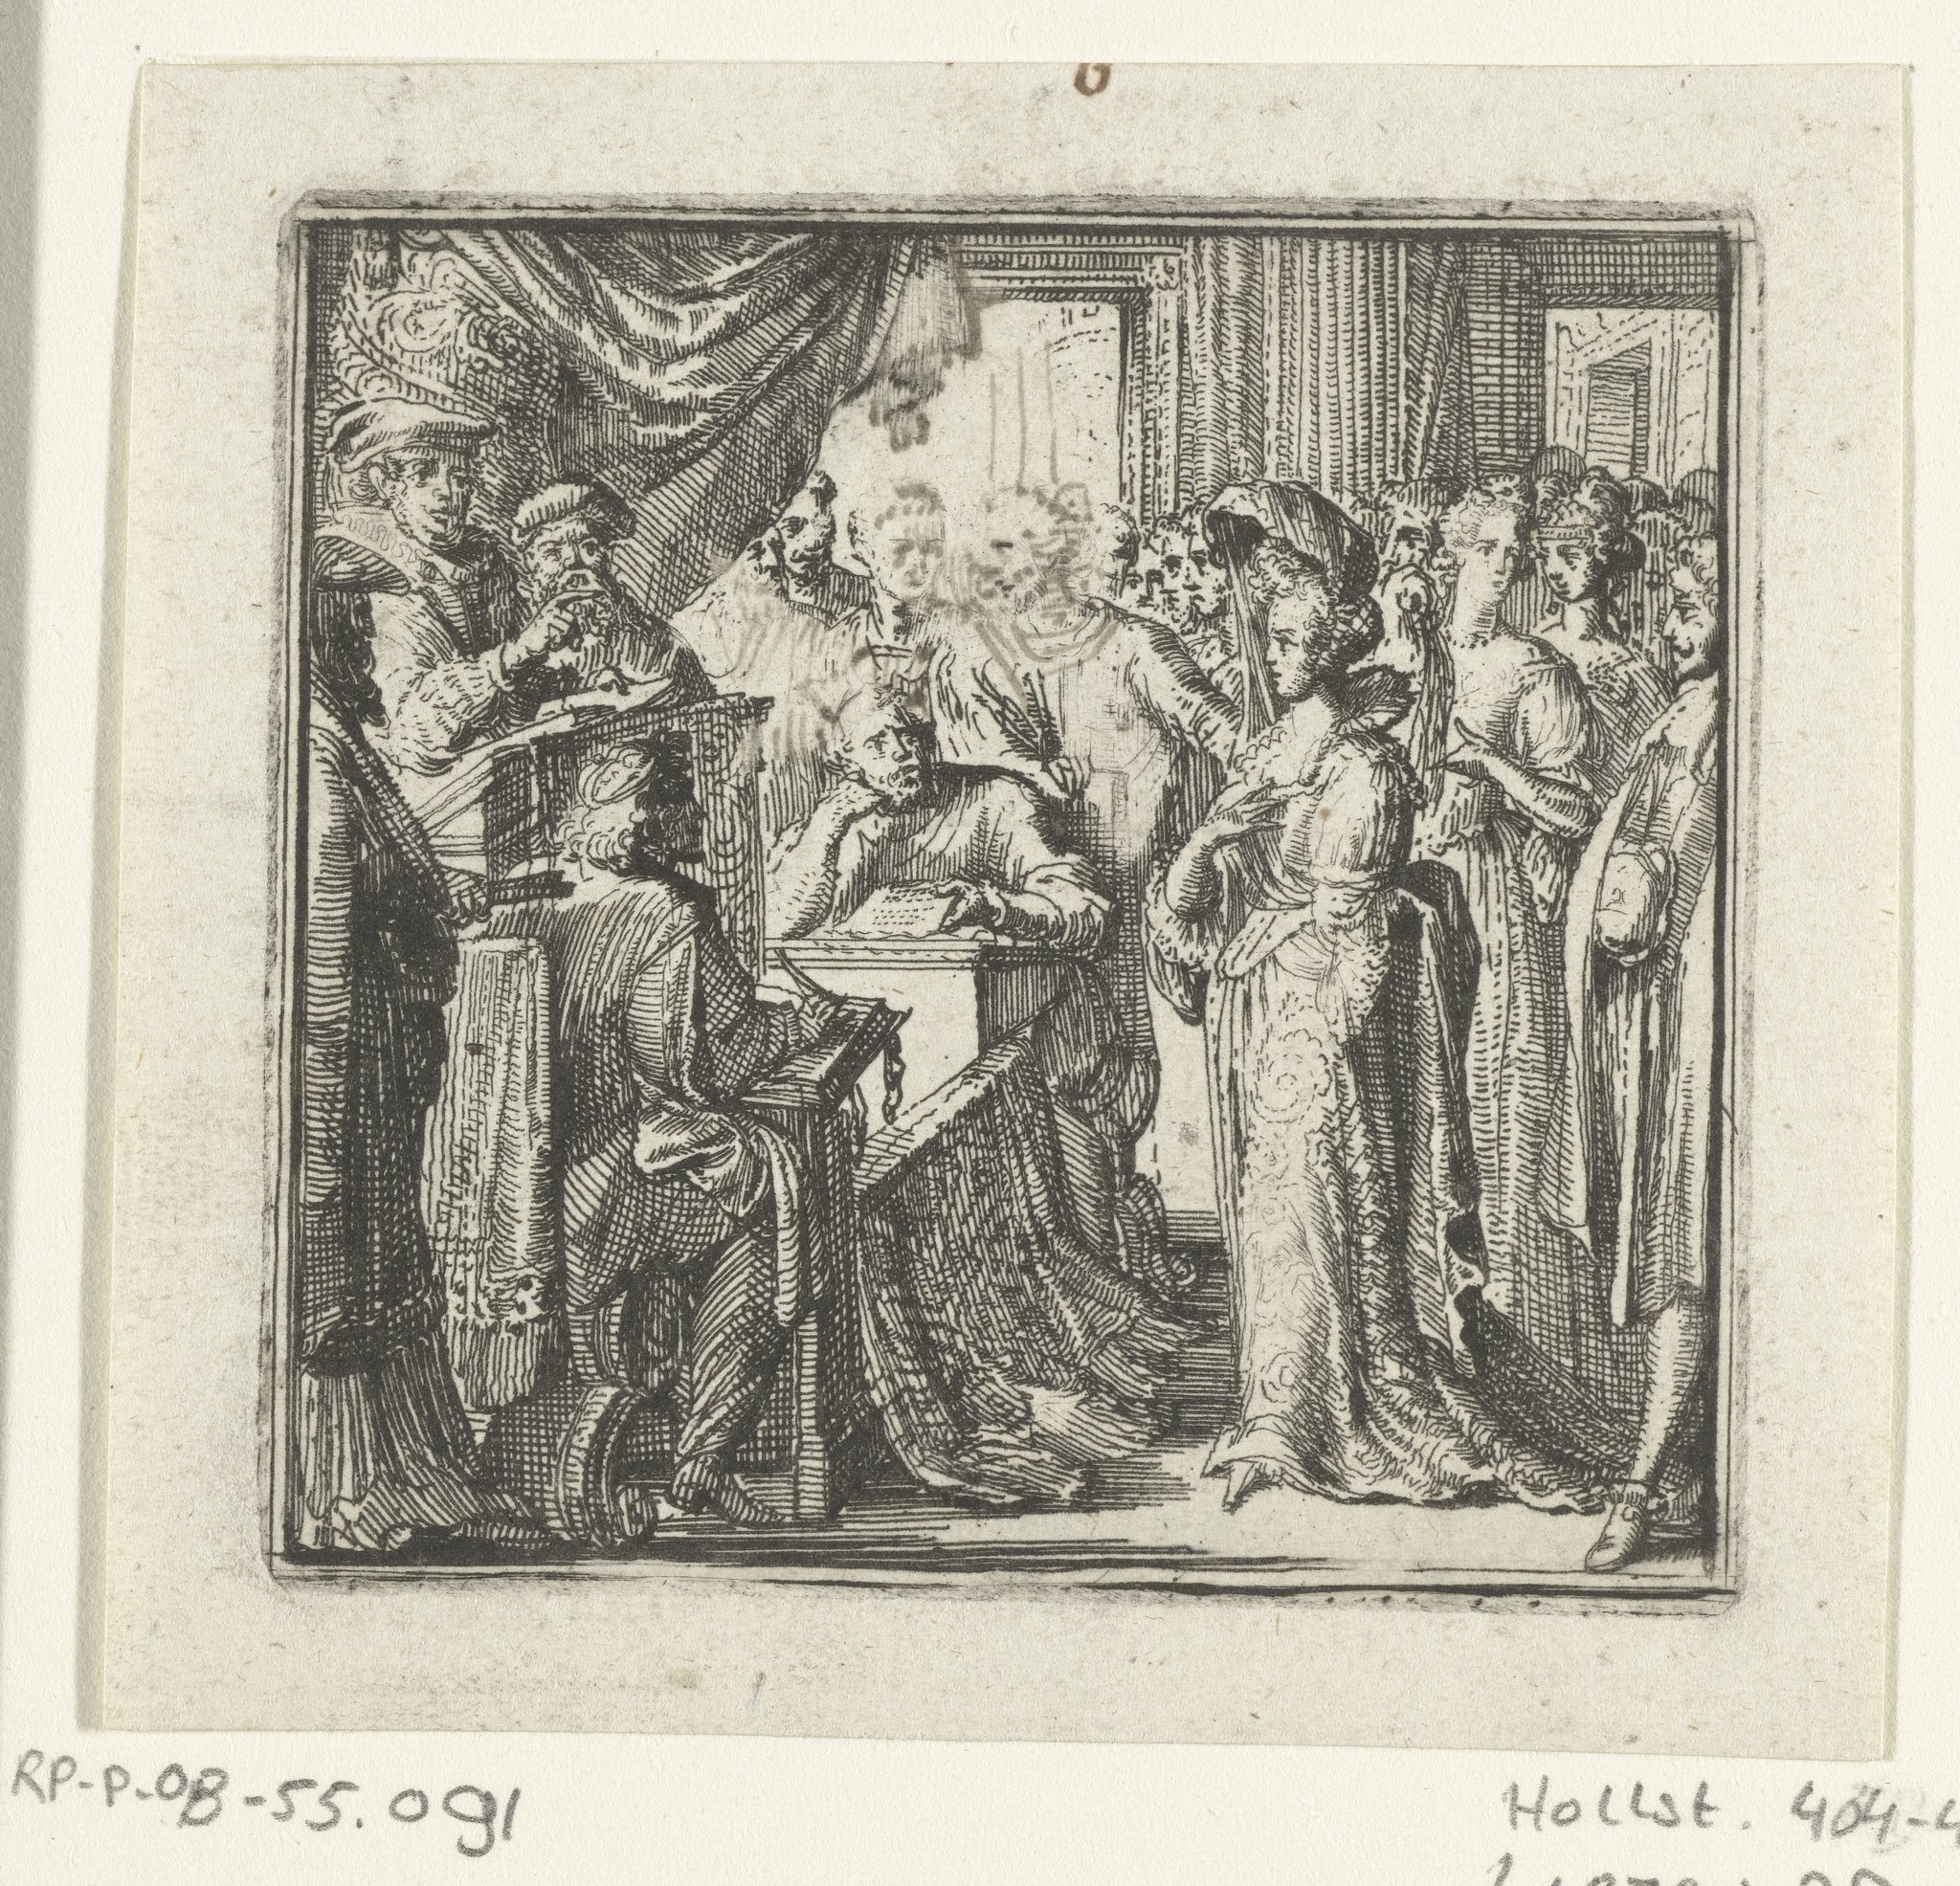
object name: book illustration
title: Illustratie voor de Decamerone van Boccaccio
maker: romeyn de hooghe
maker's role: draughtsman, goldsmith, painter, print maker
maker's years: 1645-1708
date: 1697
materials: paper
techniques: etching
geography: netherlands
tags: (scenes from) specific works of literature: boccaccio, decamerone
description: Illustratie voor: Contes et nouvelles de Bocace Florentin. Traduction libre, 2 delen, Amsterdam, George Gallet, 1697. Latere edities met dezelfde illustraties uit 1699, 1702, 1732.